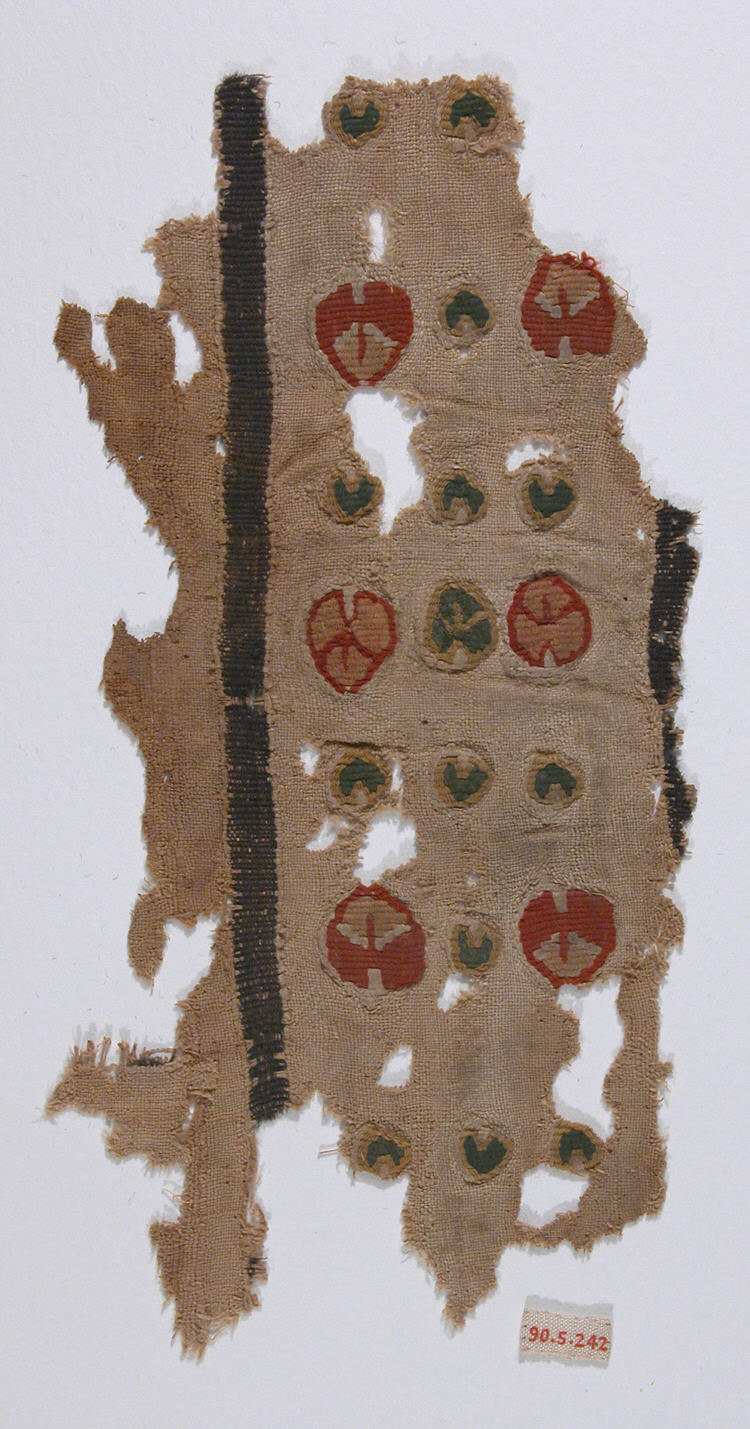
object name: textile fragment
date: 401-600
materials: linen, wool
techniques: weave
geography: egypt